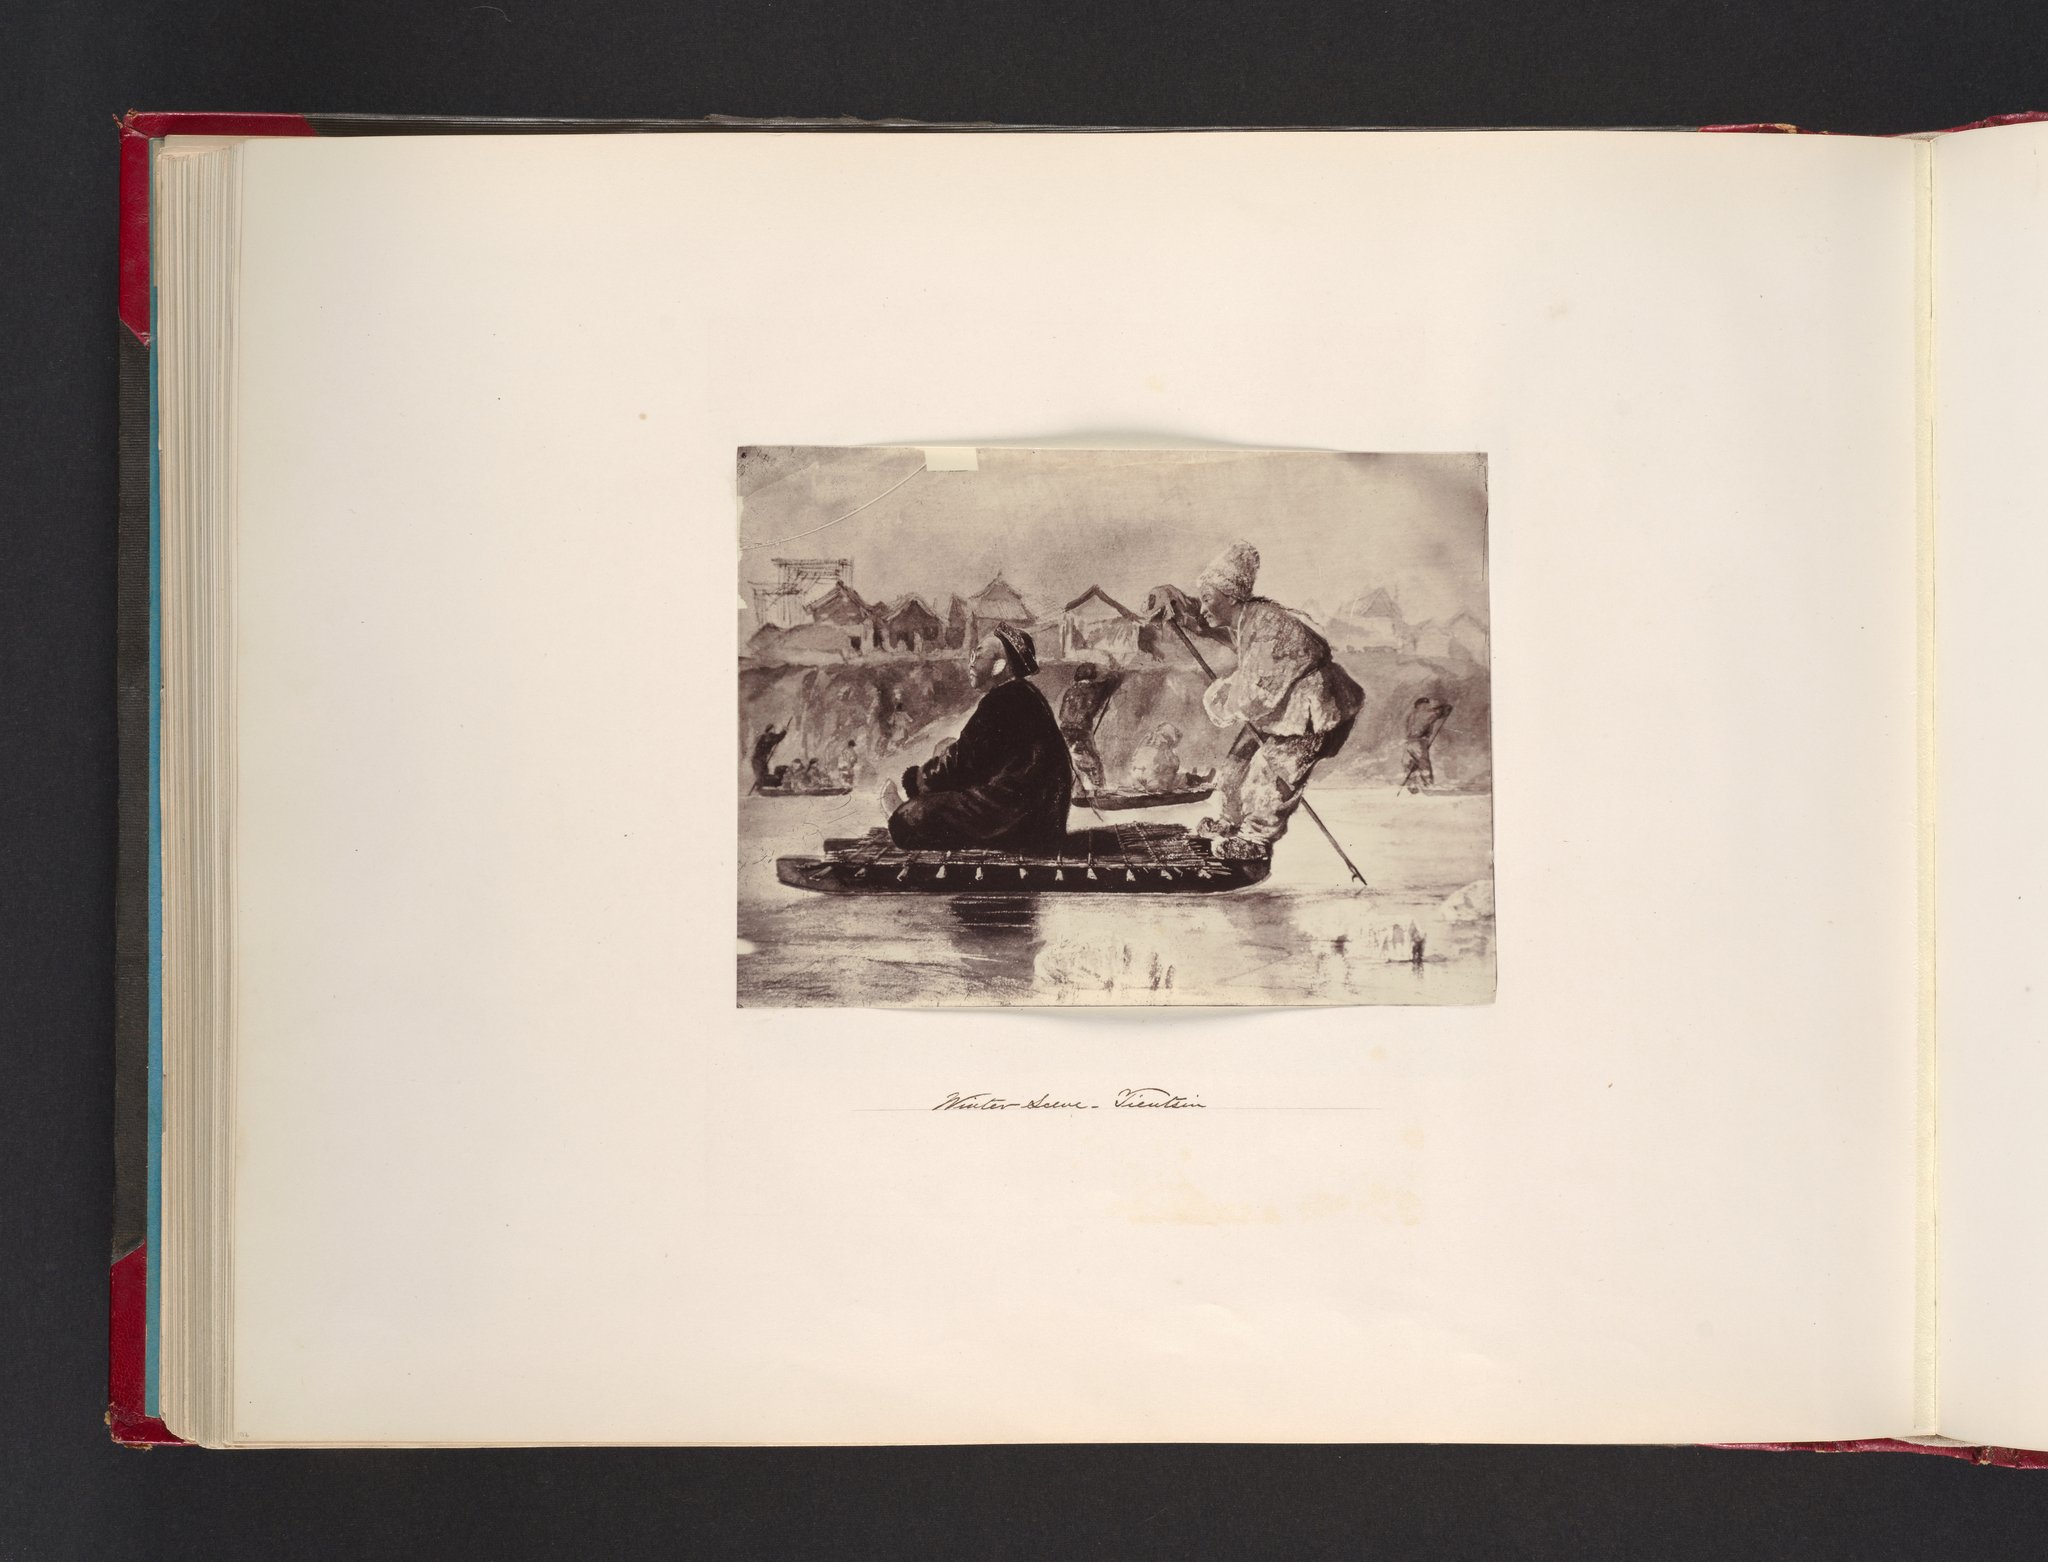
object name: photograph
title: [Drawing or Painting of Winter Scene, Tientsin]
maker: john thomson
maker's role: artist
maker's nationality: british, scottish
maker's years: 1837-1921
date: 1865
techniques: albumen silver print, glass negative